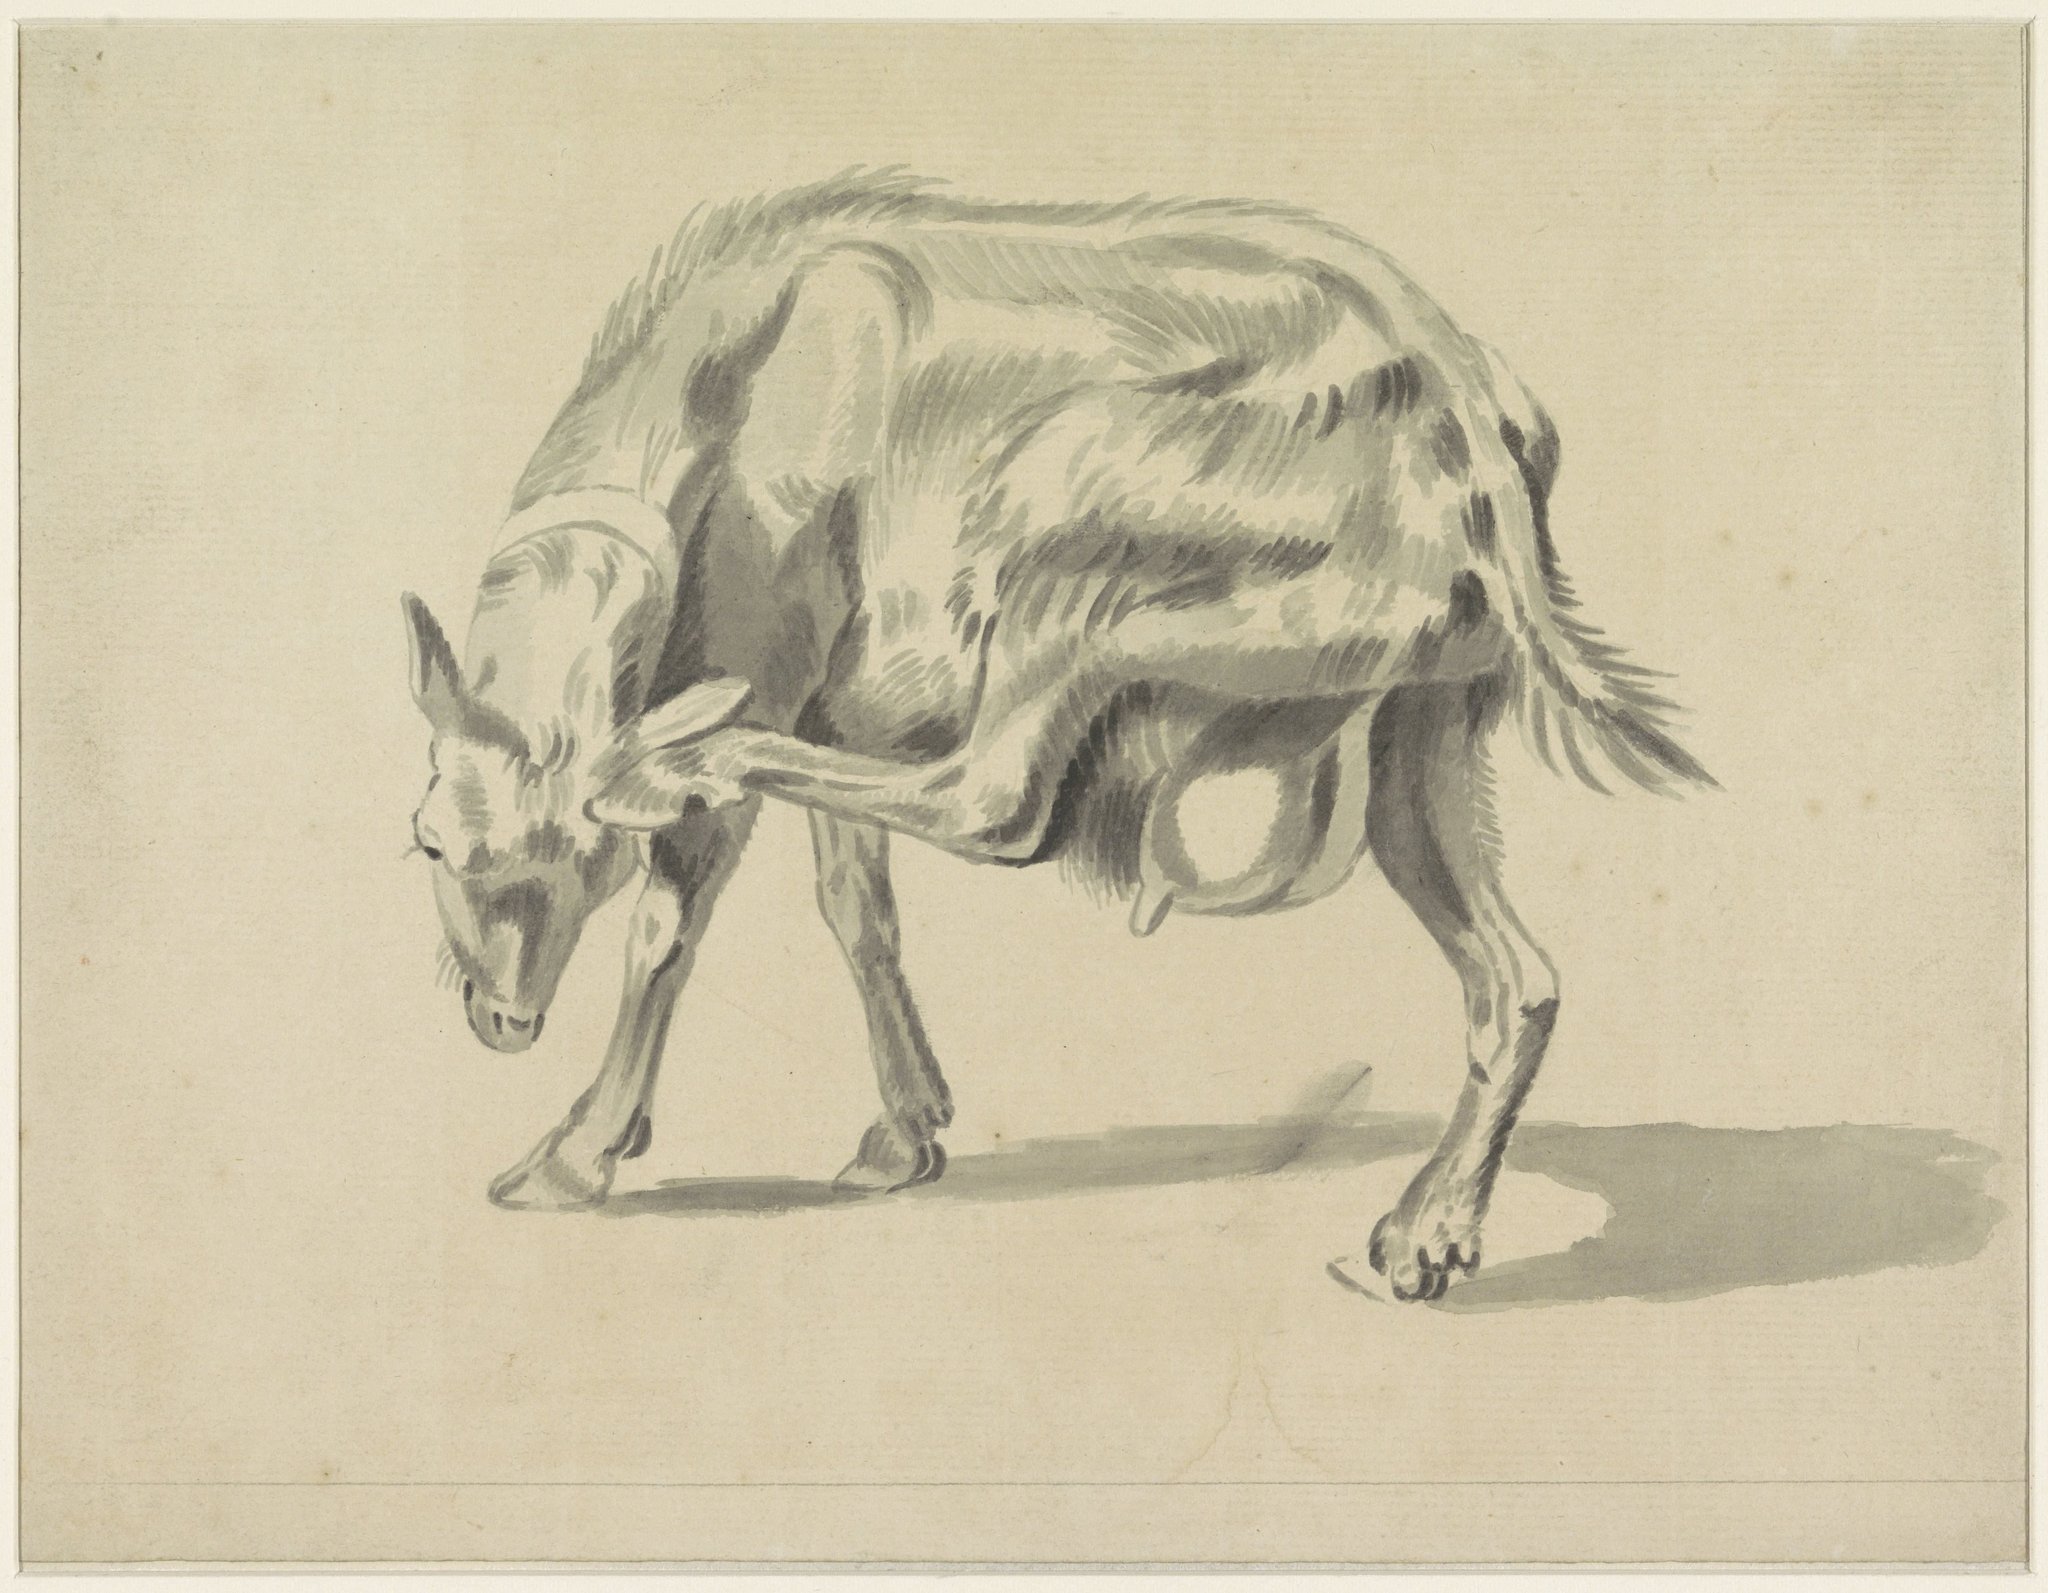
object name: drawing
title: Zich krabbende geit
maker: hendrik jozef franciscus van der poorten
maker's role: draughtsman, print maker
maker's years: 1789-1874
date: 1840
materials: paper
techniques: brush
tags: goat